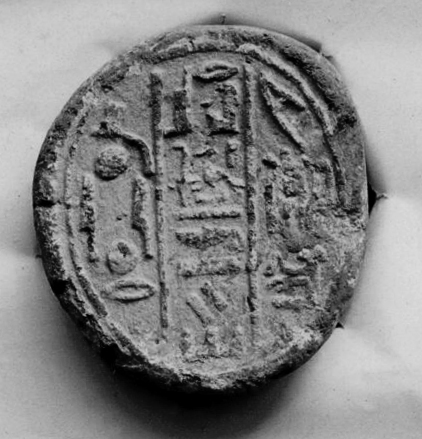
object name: cone, circular stamp, merymose, king's son, kush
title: Funerary Cone of the King's Son of Kush Merymose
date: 1550-1295 BCE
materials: pottery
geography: egypt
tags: hieroglyphs